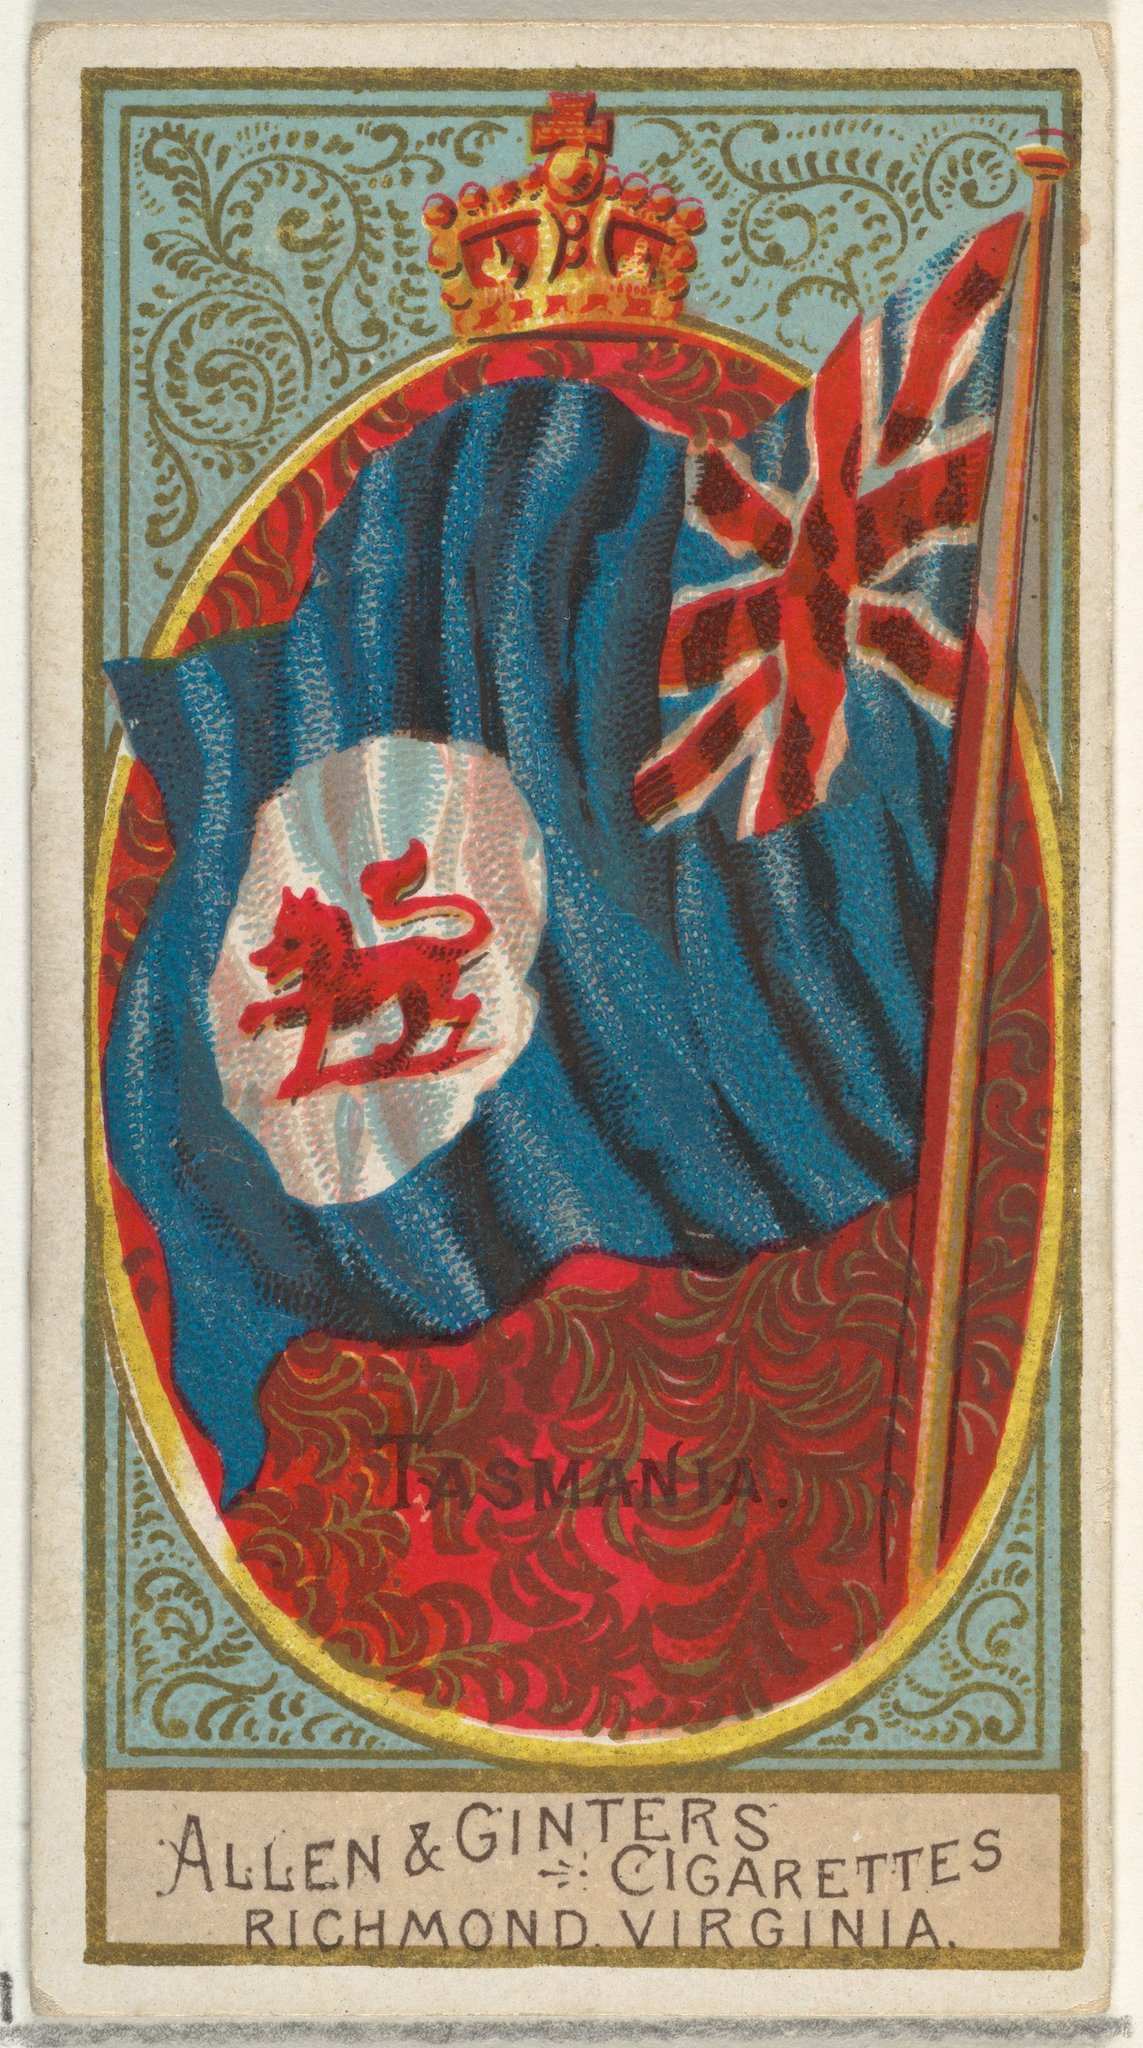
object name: print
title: Tasmania, from Flags of All Nations, Series 2 (N10) for Allen & Ginter Cigarettes Brands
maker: allen & ginter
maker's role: publisher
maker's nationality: american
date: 1890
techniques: color lithograph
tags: lions,flags